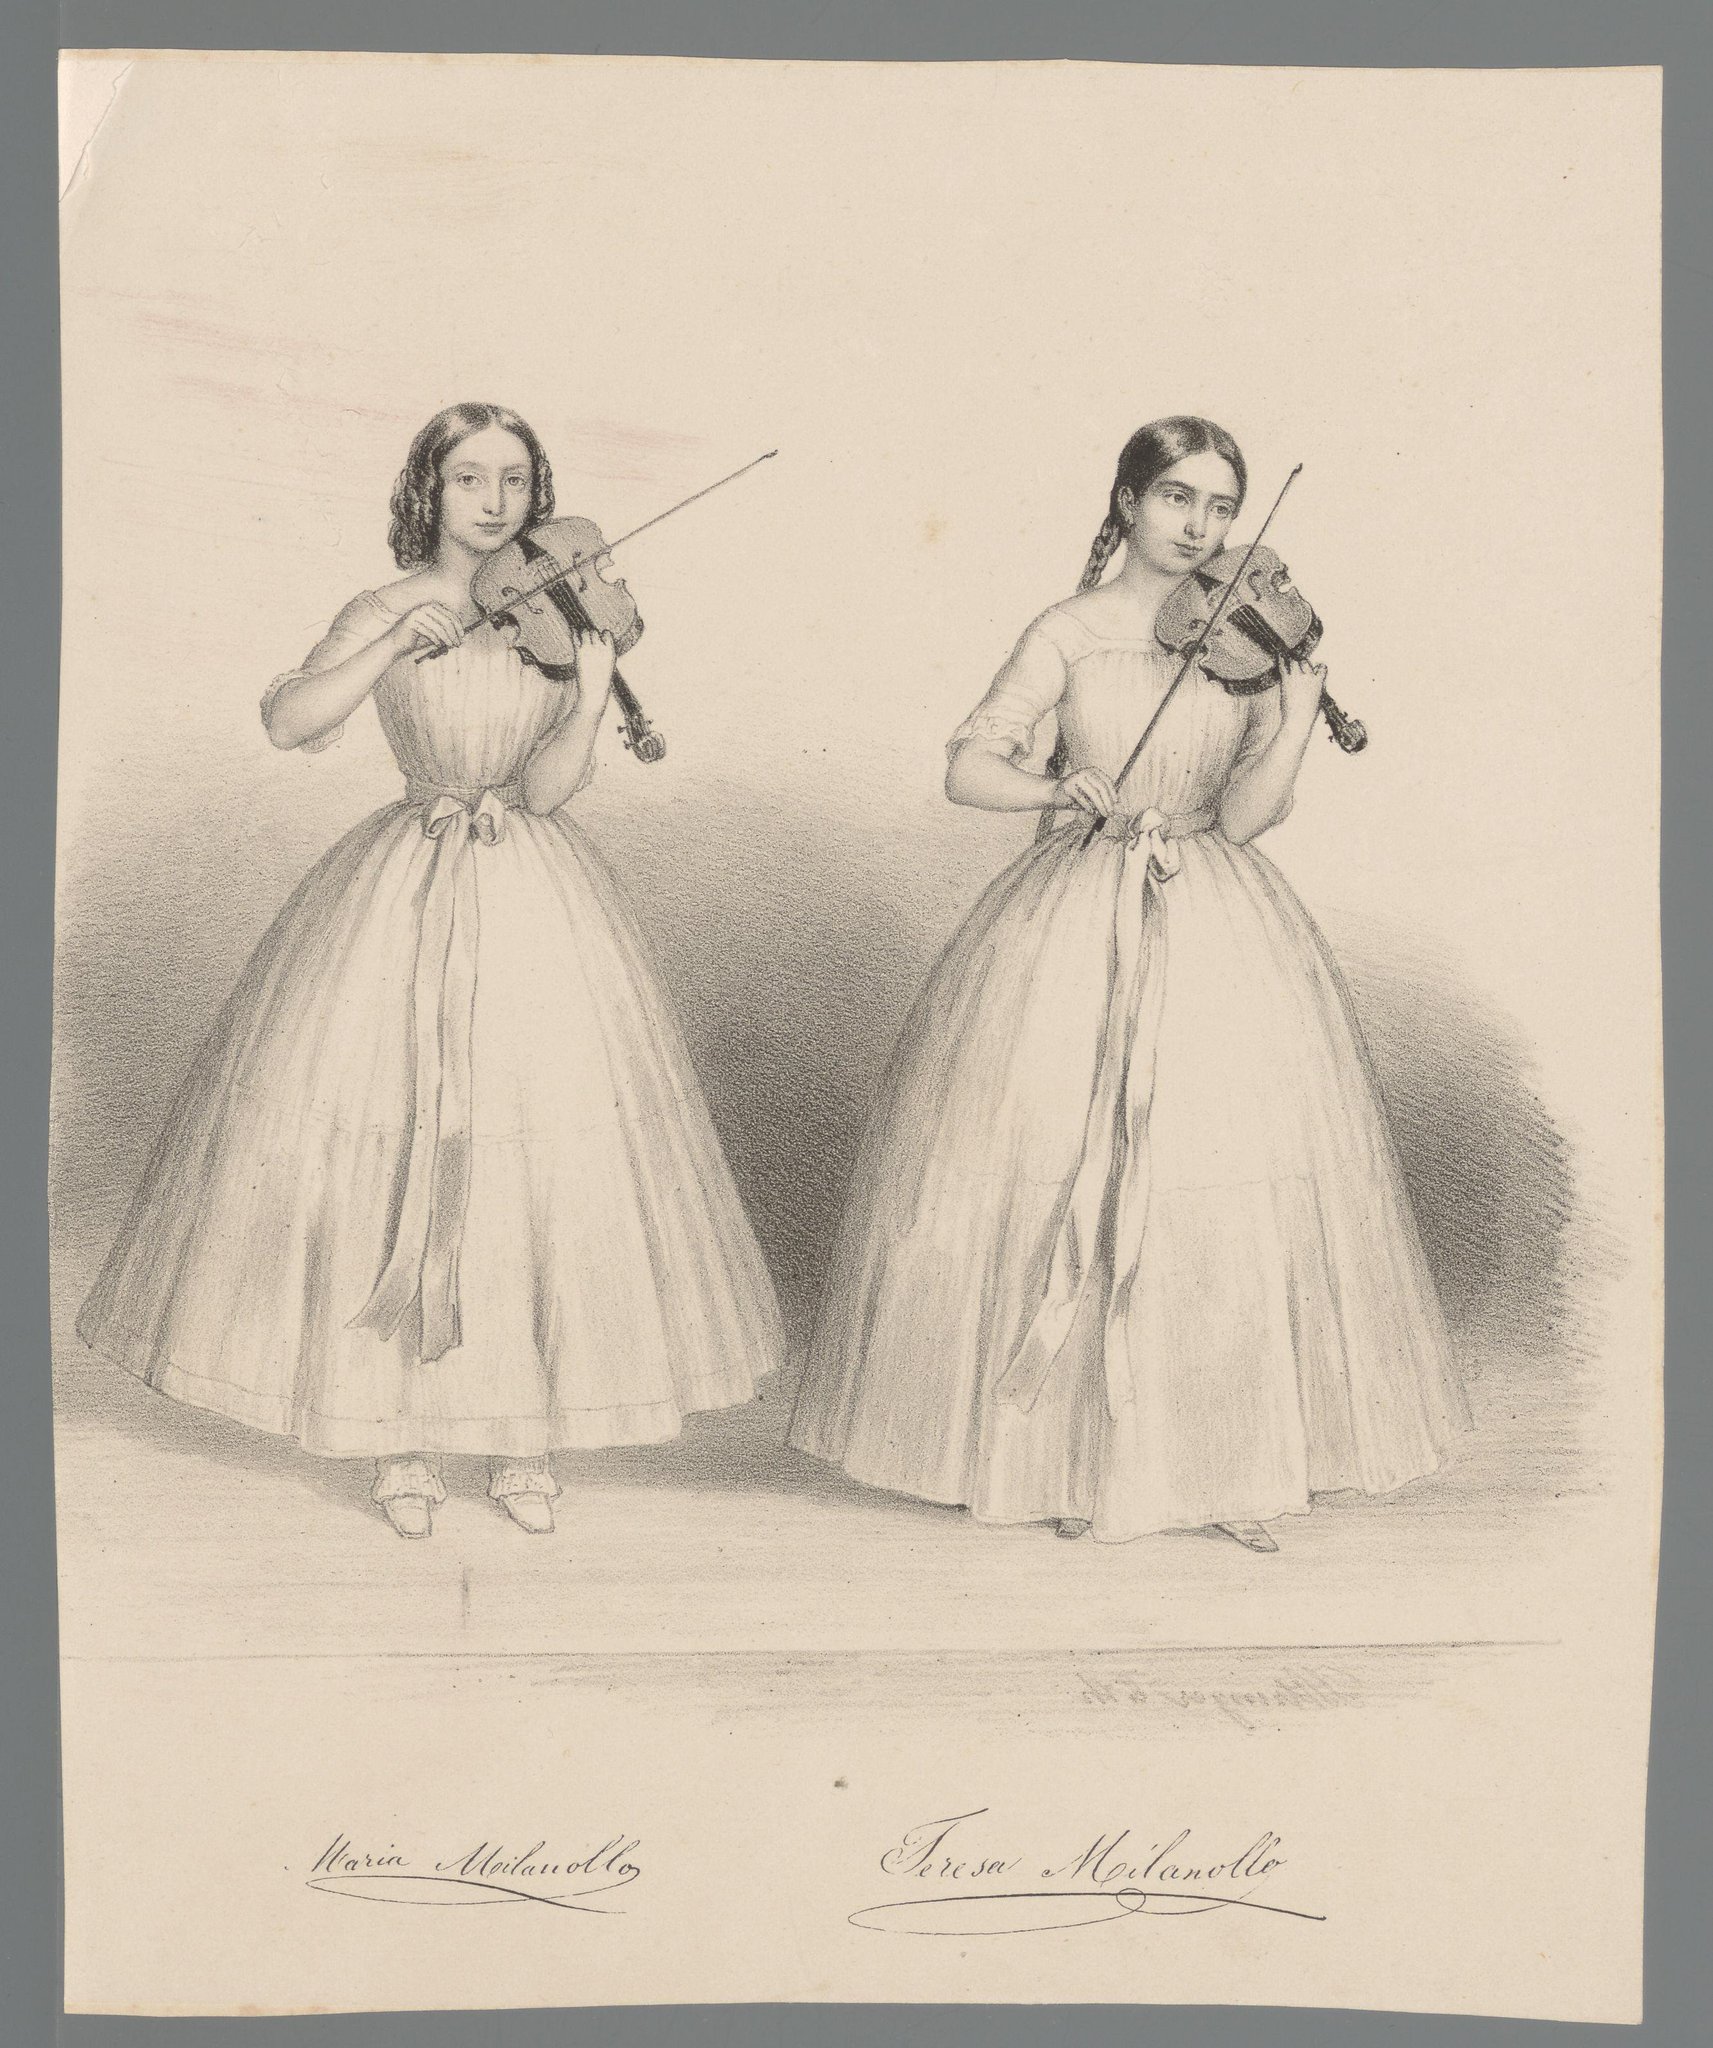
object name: print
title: Portret van Maria Milanollo en Teresa Milanollo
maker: joseph atzinger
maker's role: print maker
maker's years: 1814-1885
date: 1824-1885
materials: paper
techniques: lithograph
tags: paris, small group of musicians, chamber orchestra, jazz band, violin, fiddle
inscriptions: collector's mark: Lugt 2228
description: De zusjes Maria Milanollo (links) en Teresa Milanollo (rechts), vioolspelend, staand naast elkaar, van voren gezien. De zusjes werden 'de engelen van de viool' genoemd en waren midden negentiende eeuw zeer beroemd.